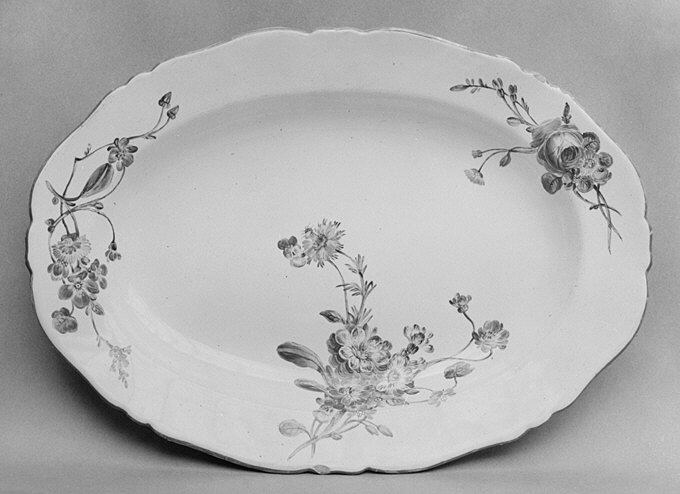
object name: platter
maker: gaspard robert manufactory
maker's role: manufactory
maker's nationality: french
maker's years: 1759-1793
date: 1760-1770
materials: faience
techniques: glazing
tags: flowers